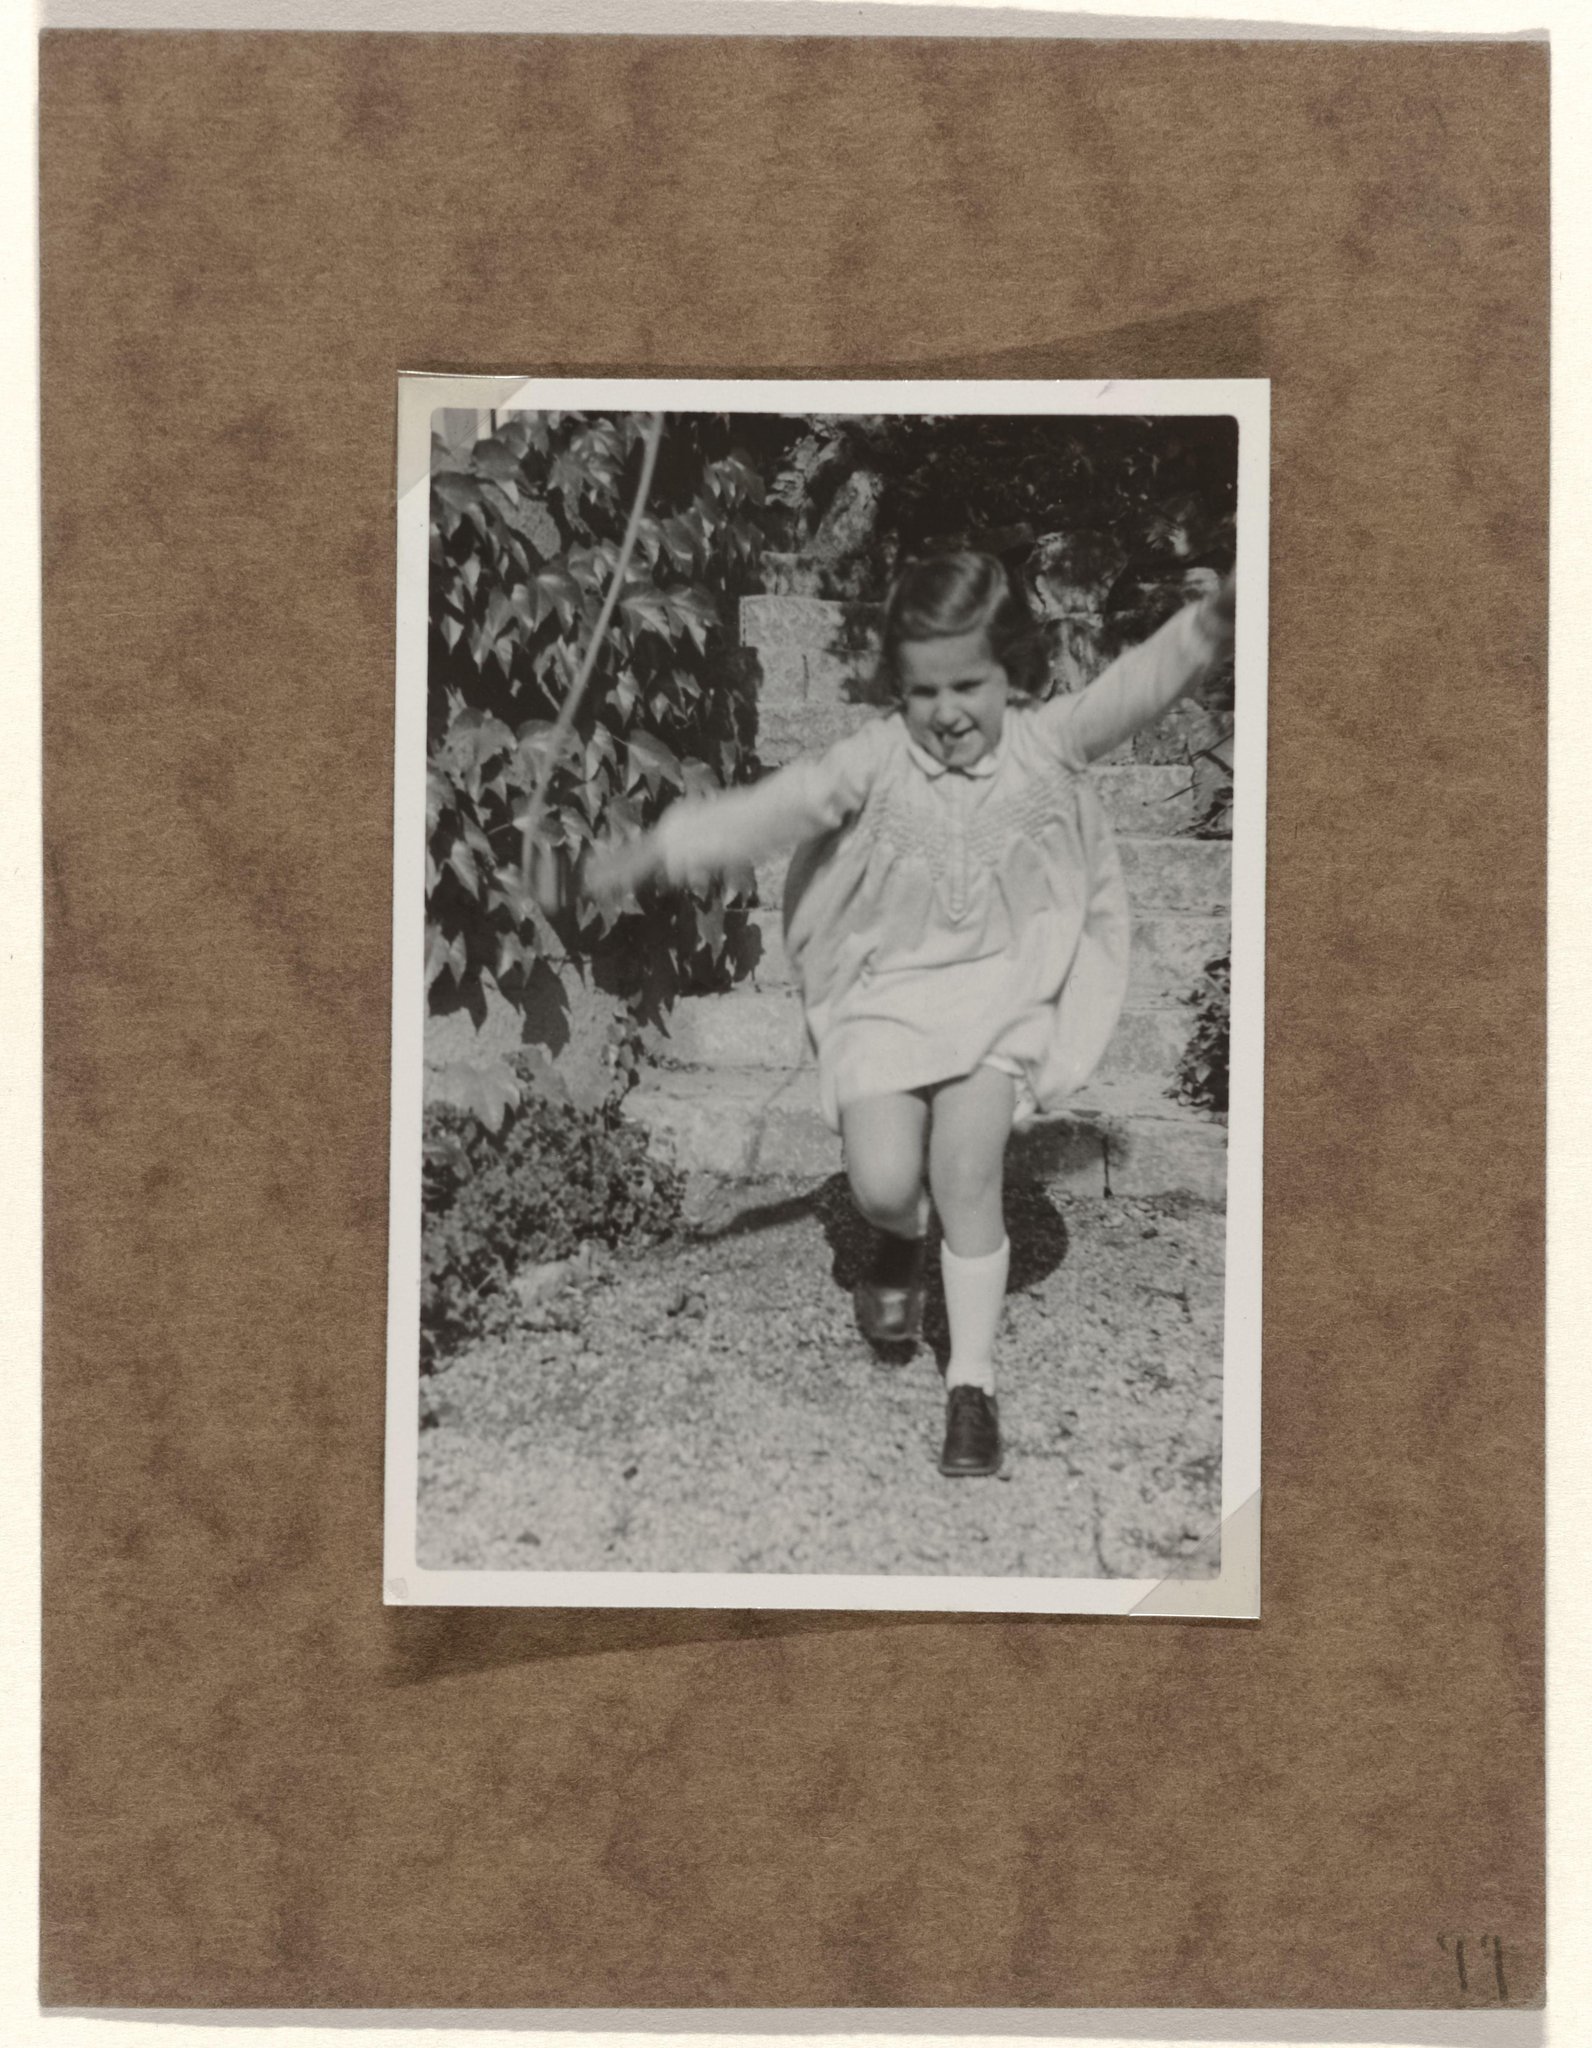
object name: photograph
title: Isabel Wachenheimer buiten bij een stenen trap, in Stuttgart oktober 1934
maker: Anonymous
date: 1910-1934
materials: photographic support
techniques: gelatin silver print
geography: stuttgart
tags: leiden, isabel wachenheimer-elon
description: Isabel Wachenheimer bij een stenen trap met begroeiing.